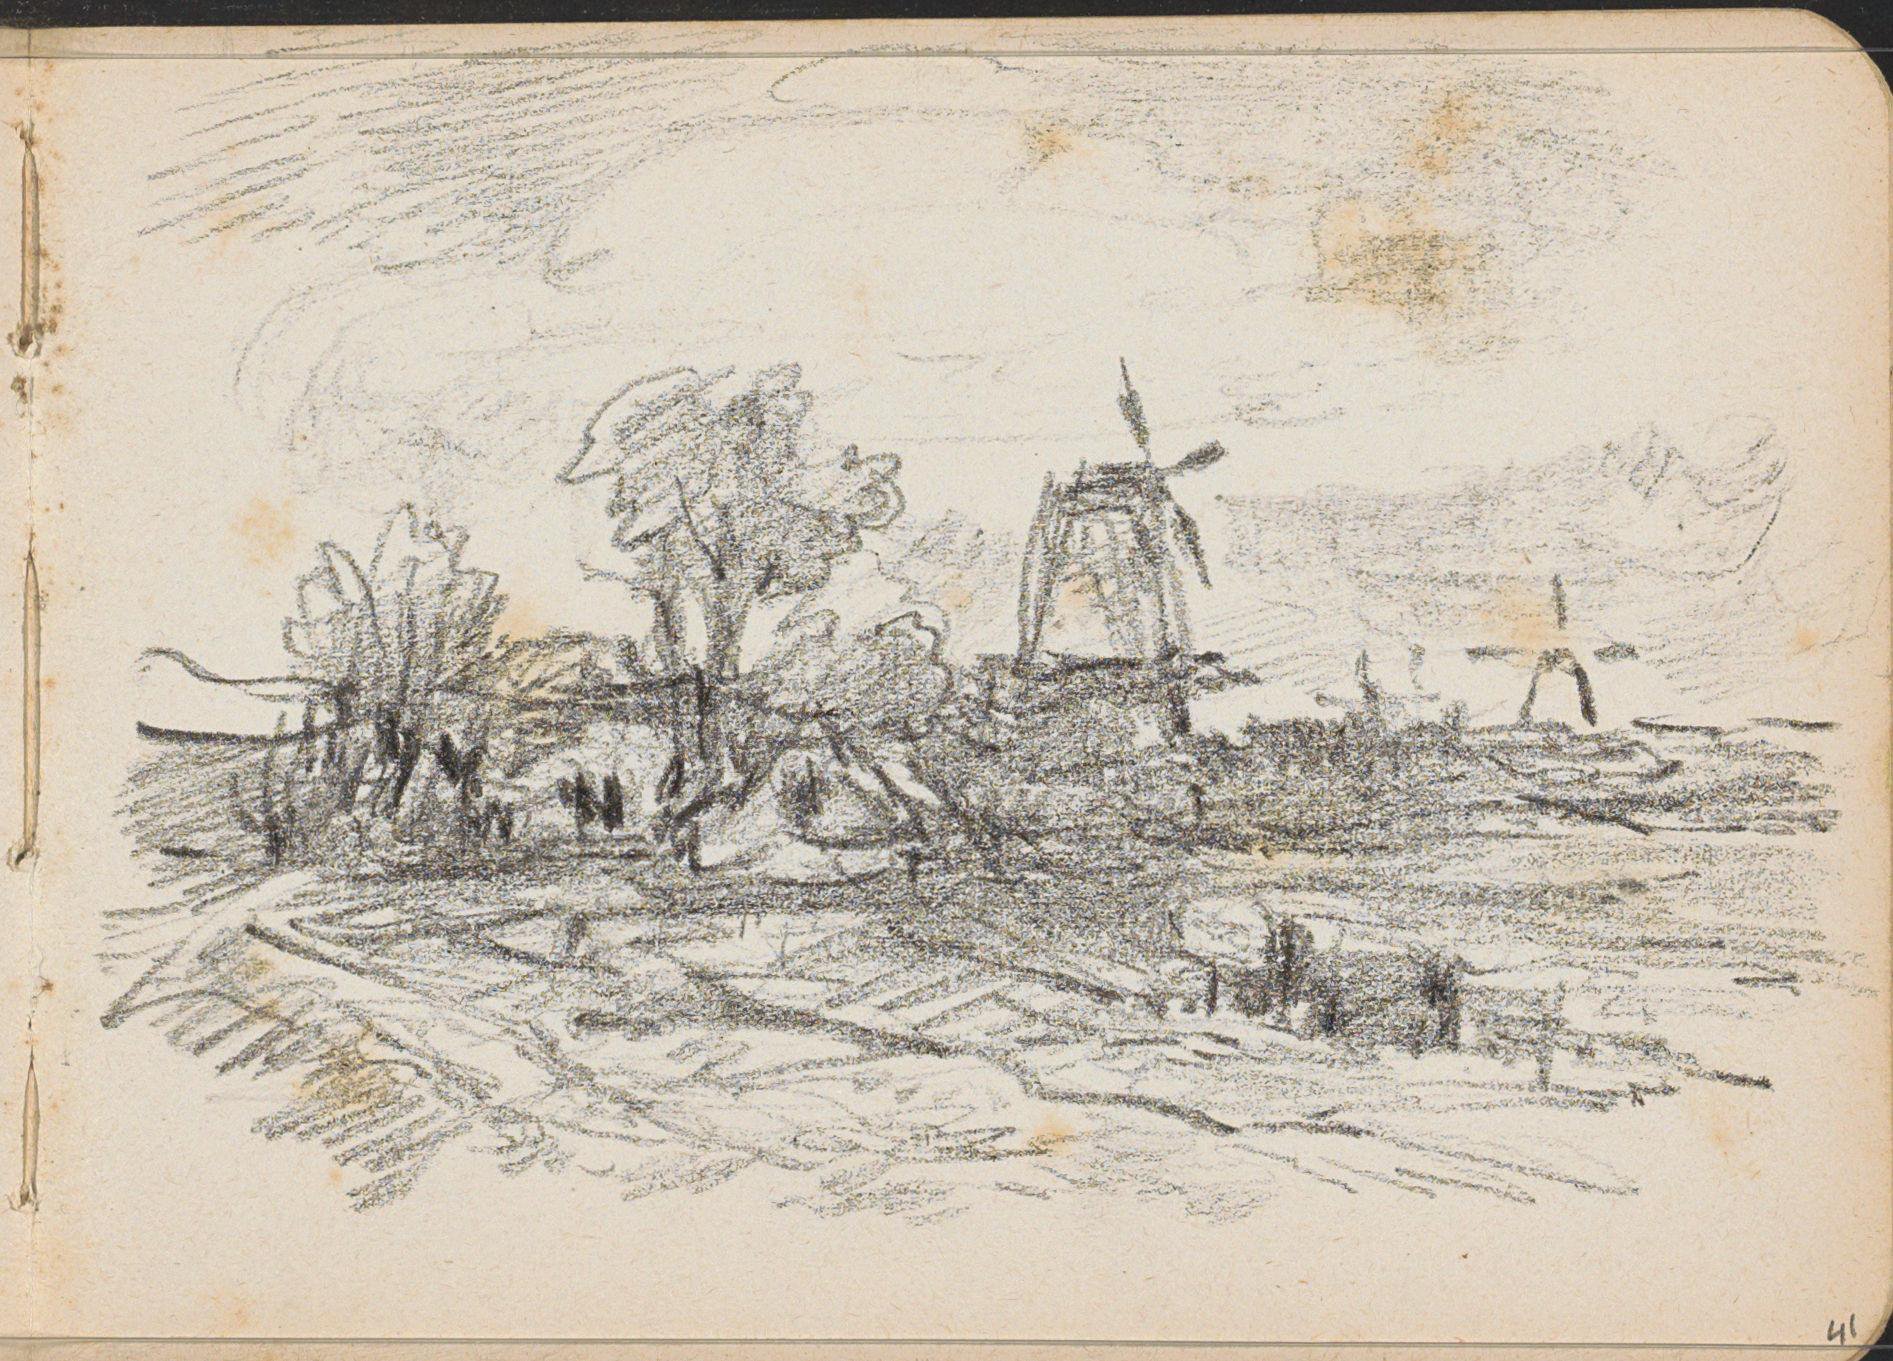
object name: sketchbook leaf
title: Landschap met molens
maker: willem cornelis rip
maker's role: draughtsman, painter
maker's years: 1856-1922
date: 1866-1922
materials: chalk, paper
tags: windmill in landscape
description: Blad 41 recto uit een schetsboek met 44 bladen.